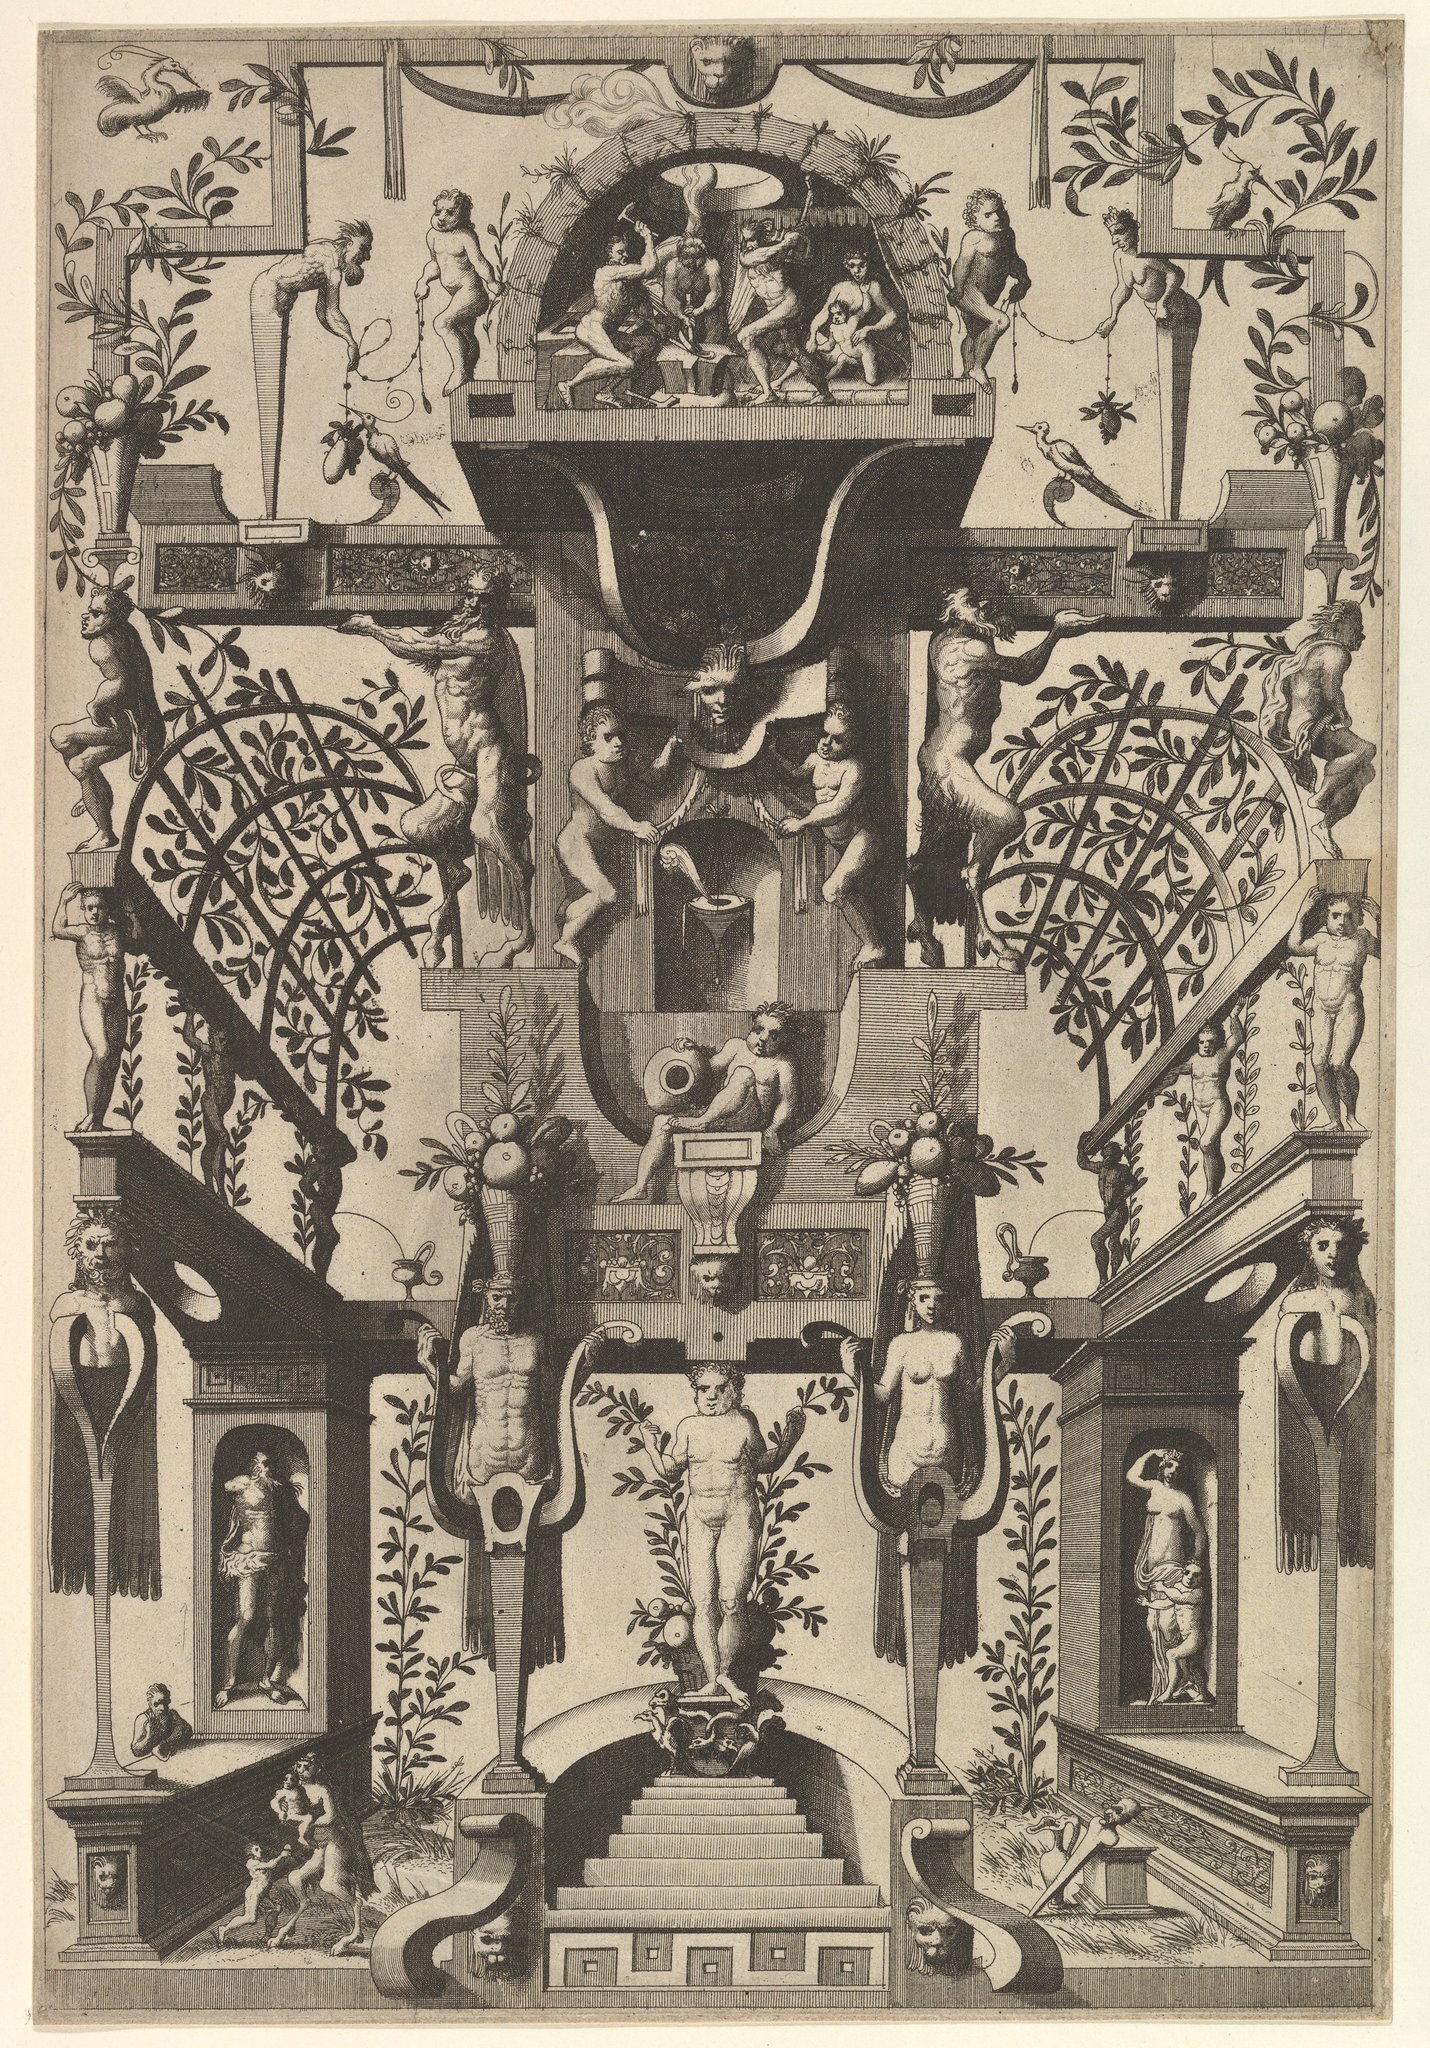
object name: print collection ornament architecture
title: Modern Grotesque Decoration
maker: johannes van doetecum i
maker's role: artist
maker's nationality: netherlandish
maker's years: 1528-1605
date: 1557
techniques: etching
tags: grotesques,ornament,mythical creatures,satyrs